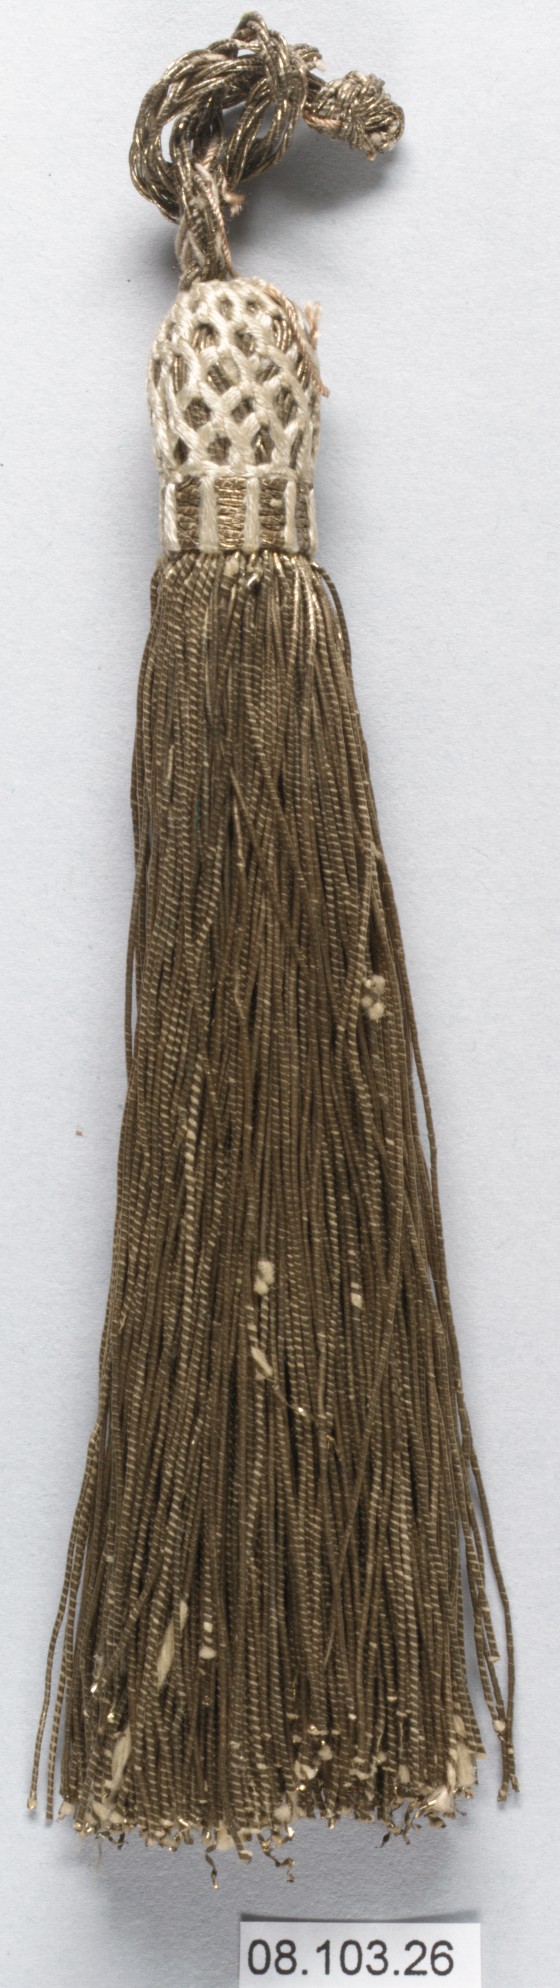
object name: tassel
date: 1701-1800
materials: metal thread